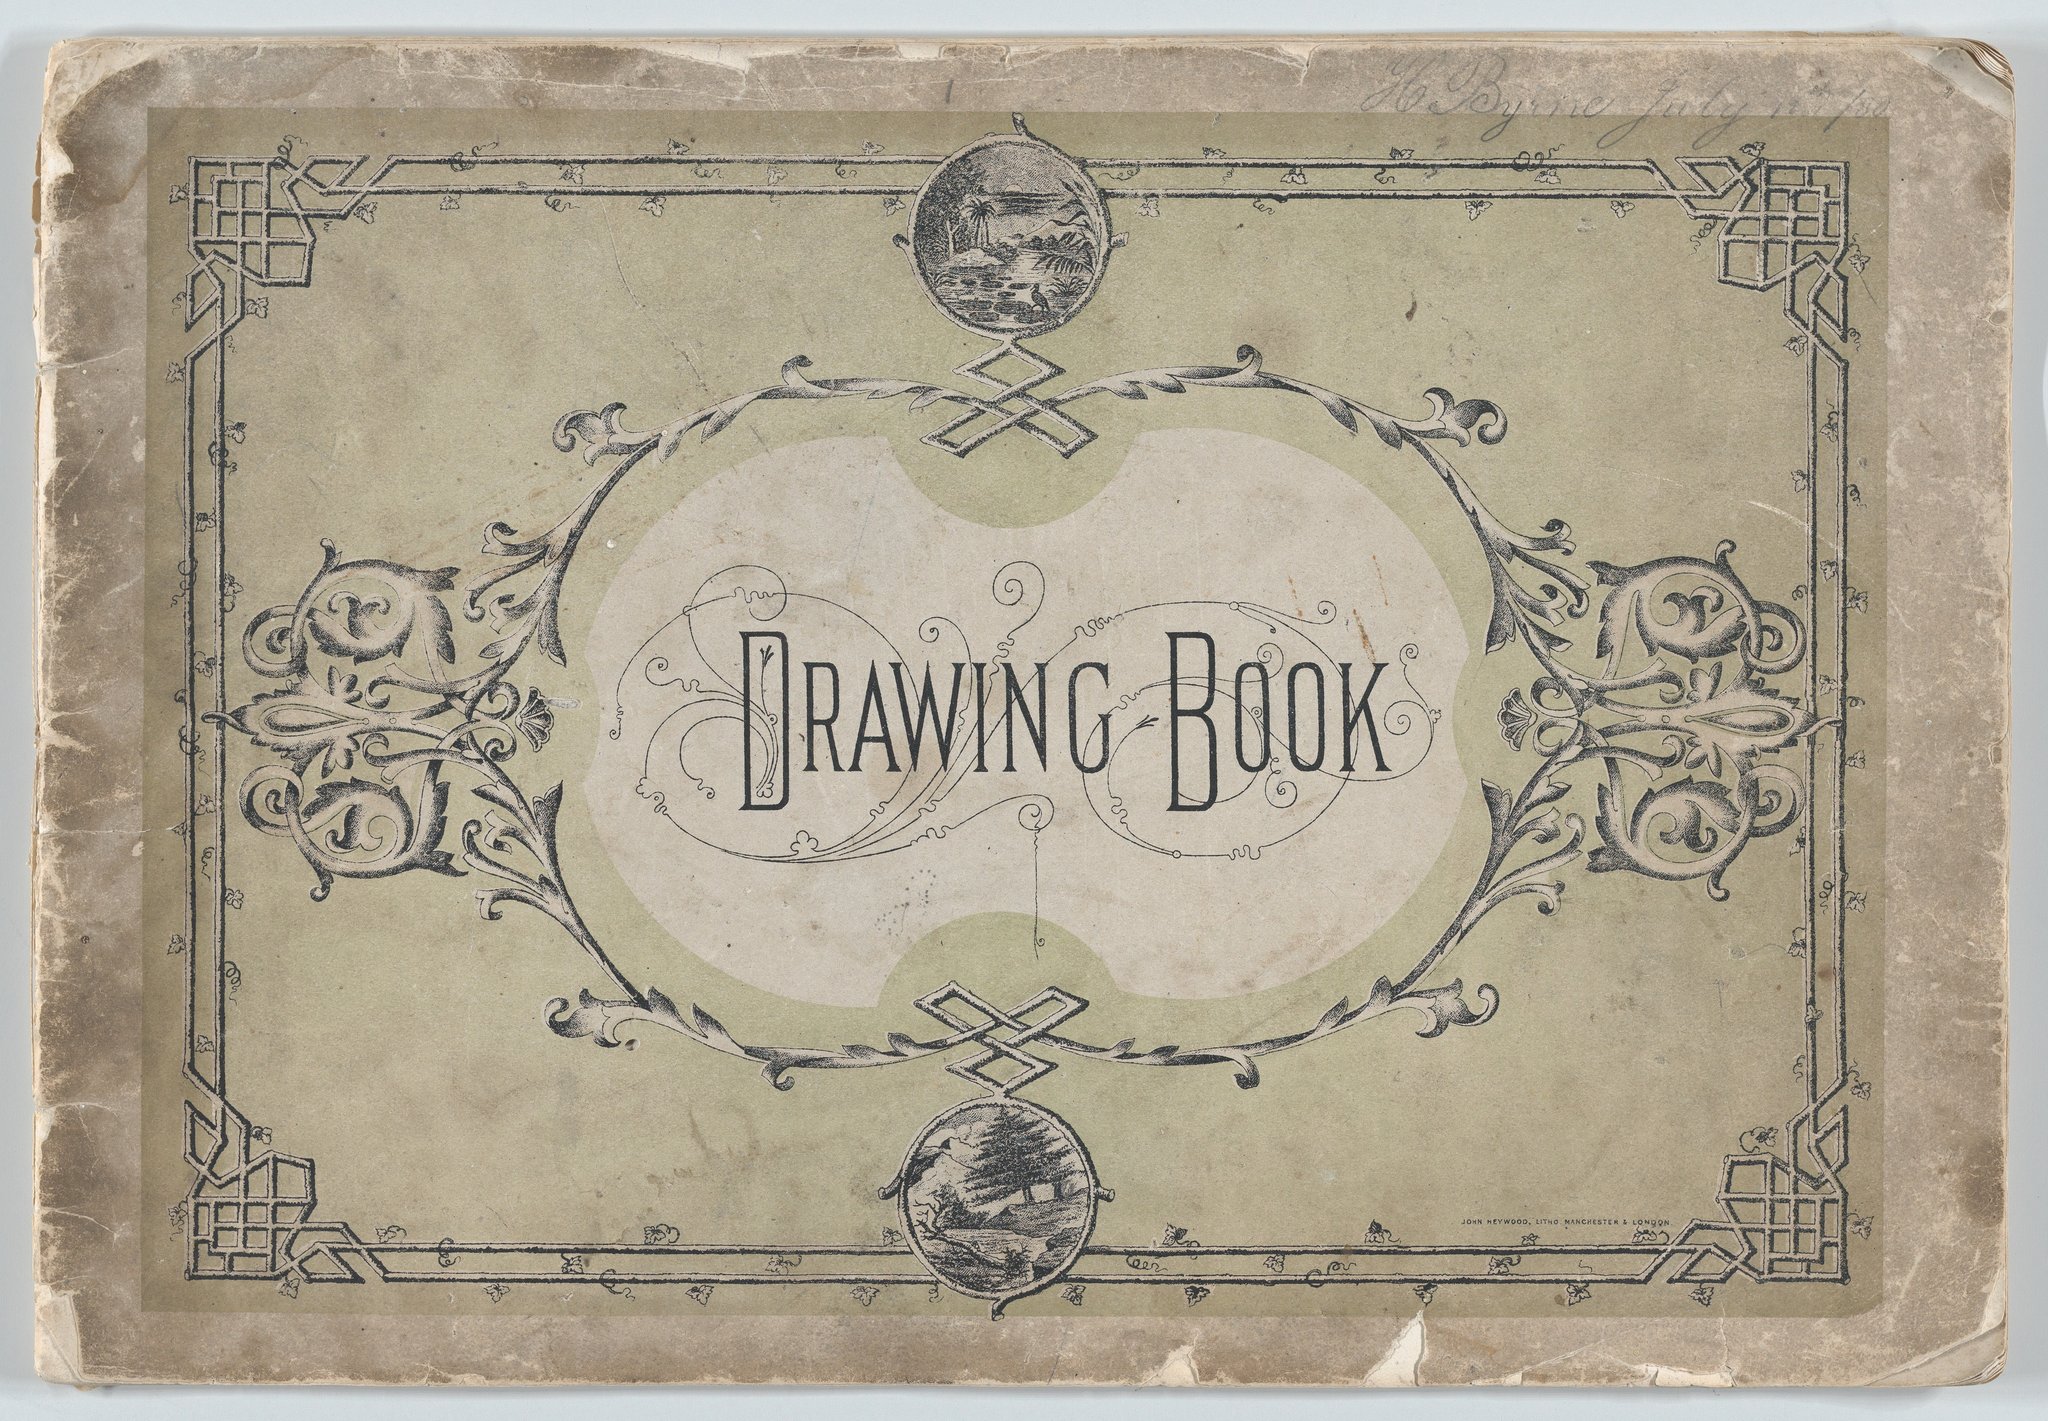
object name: drawing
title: Drawing Book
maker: h. byrne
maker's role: artist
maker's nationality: british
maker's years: 1880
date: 1880-1881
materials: chalk, graphite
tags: ornament